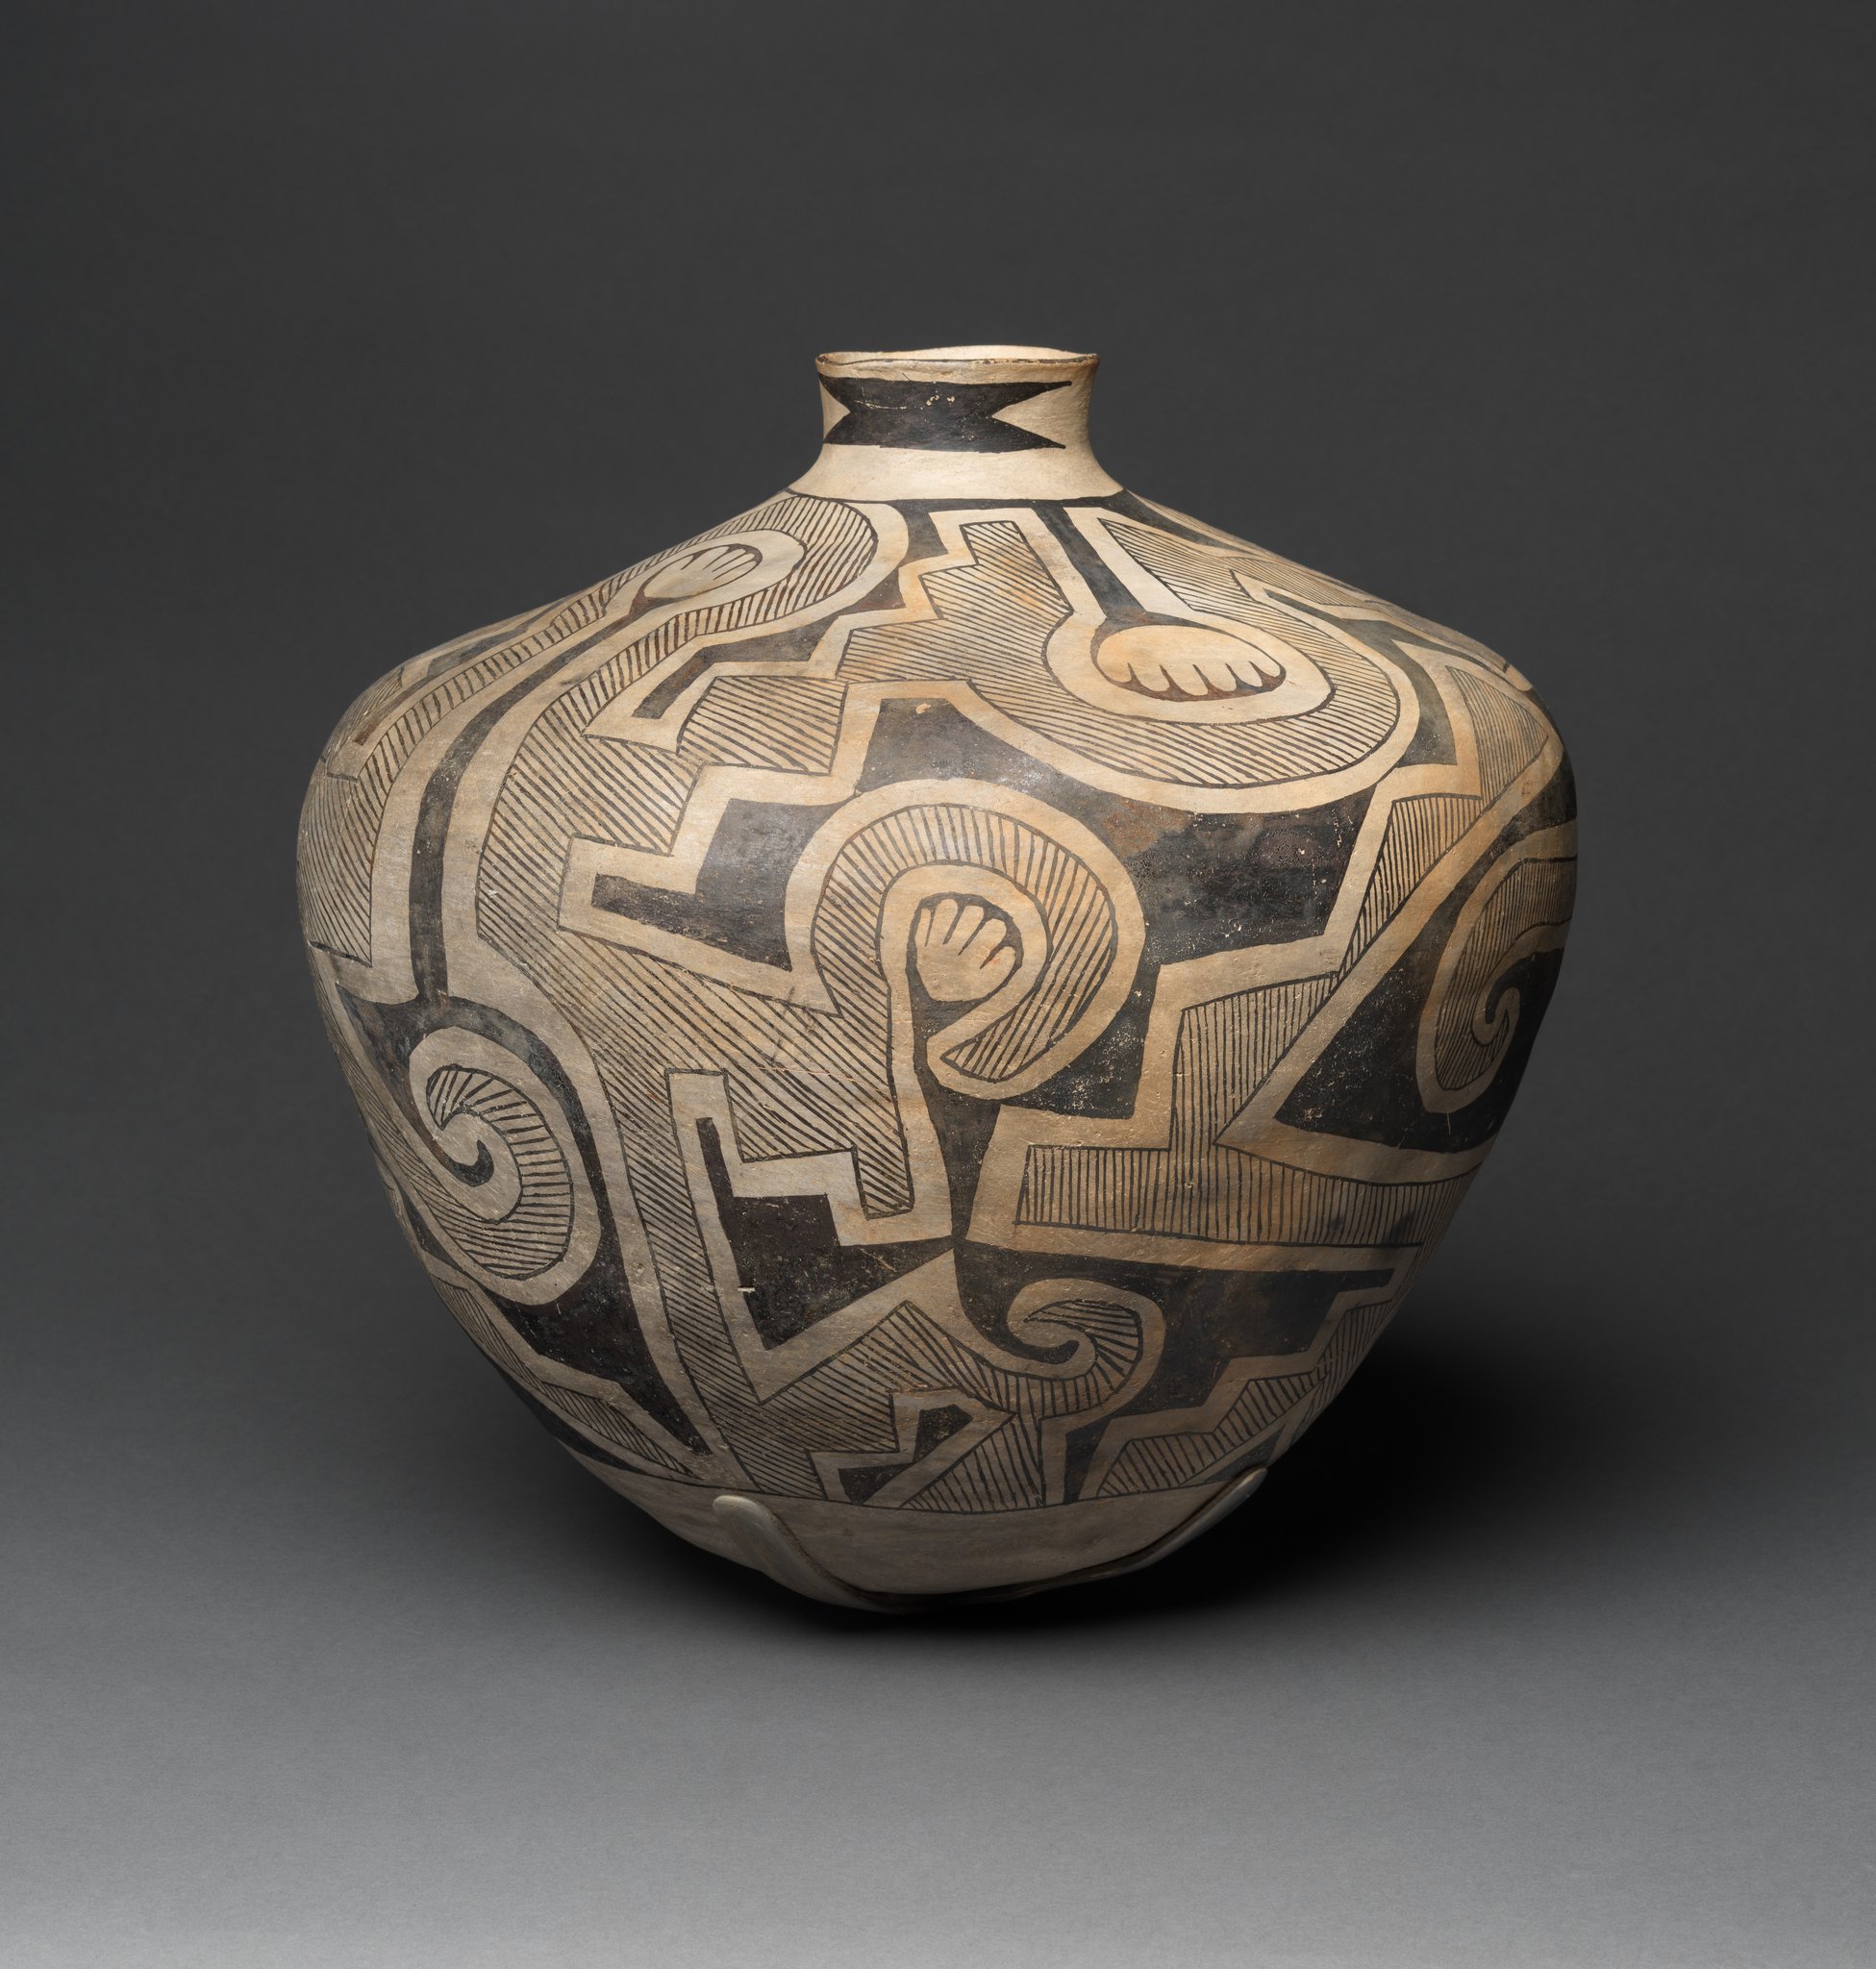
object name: storage jar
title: Socorro black-on-white storage jar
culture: ancestral pueblo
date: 1050-1100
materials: clay, pigment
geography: united states